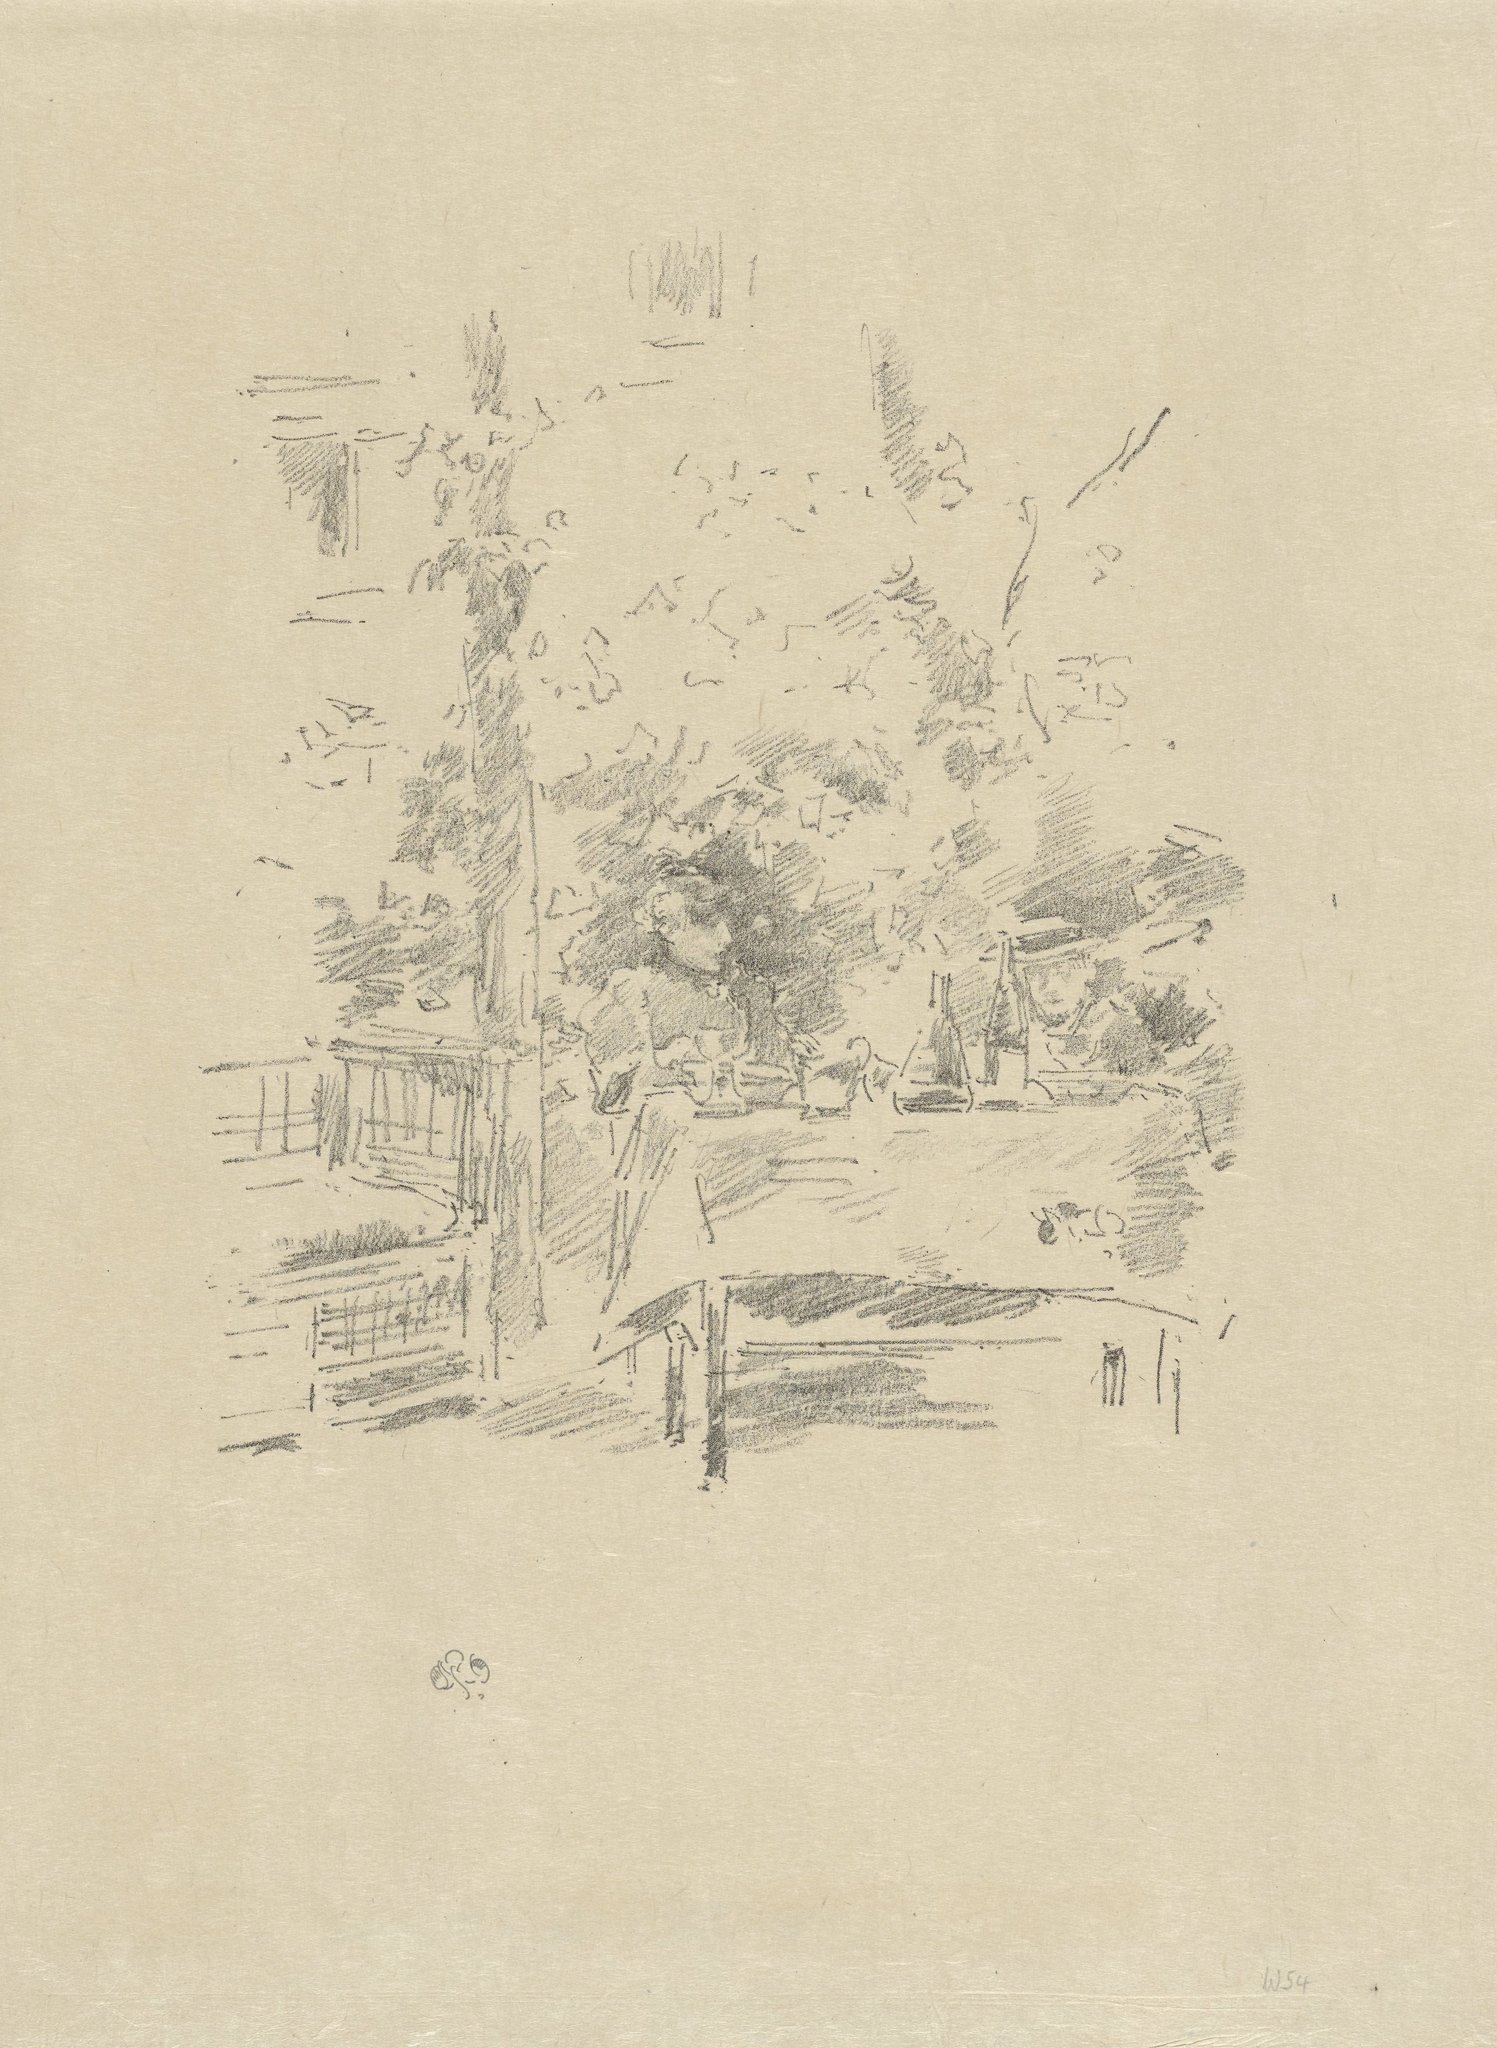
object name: print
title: Tête-a-tête in the garden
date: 1894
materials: paper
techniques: lithograph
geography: london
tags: garden, open-air recreation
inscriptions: signature: ‘JW’, collector's mark: Lugt 405, collector's mark: Lugt 2228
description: Een man en vrouw gezeten aan een gedekte tafel in een tuin.